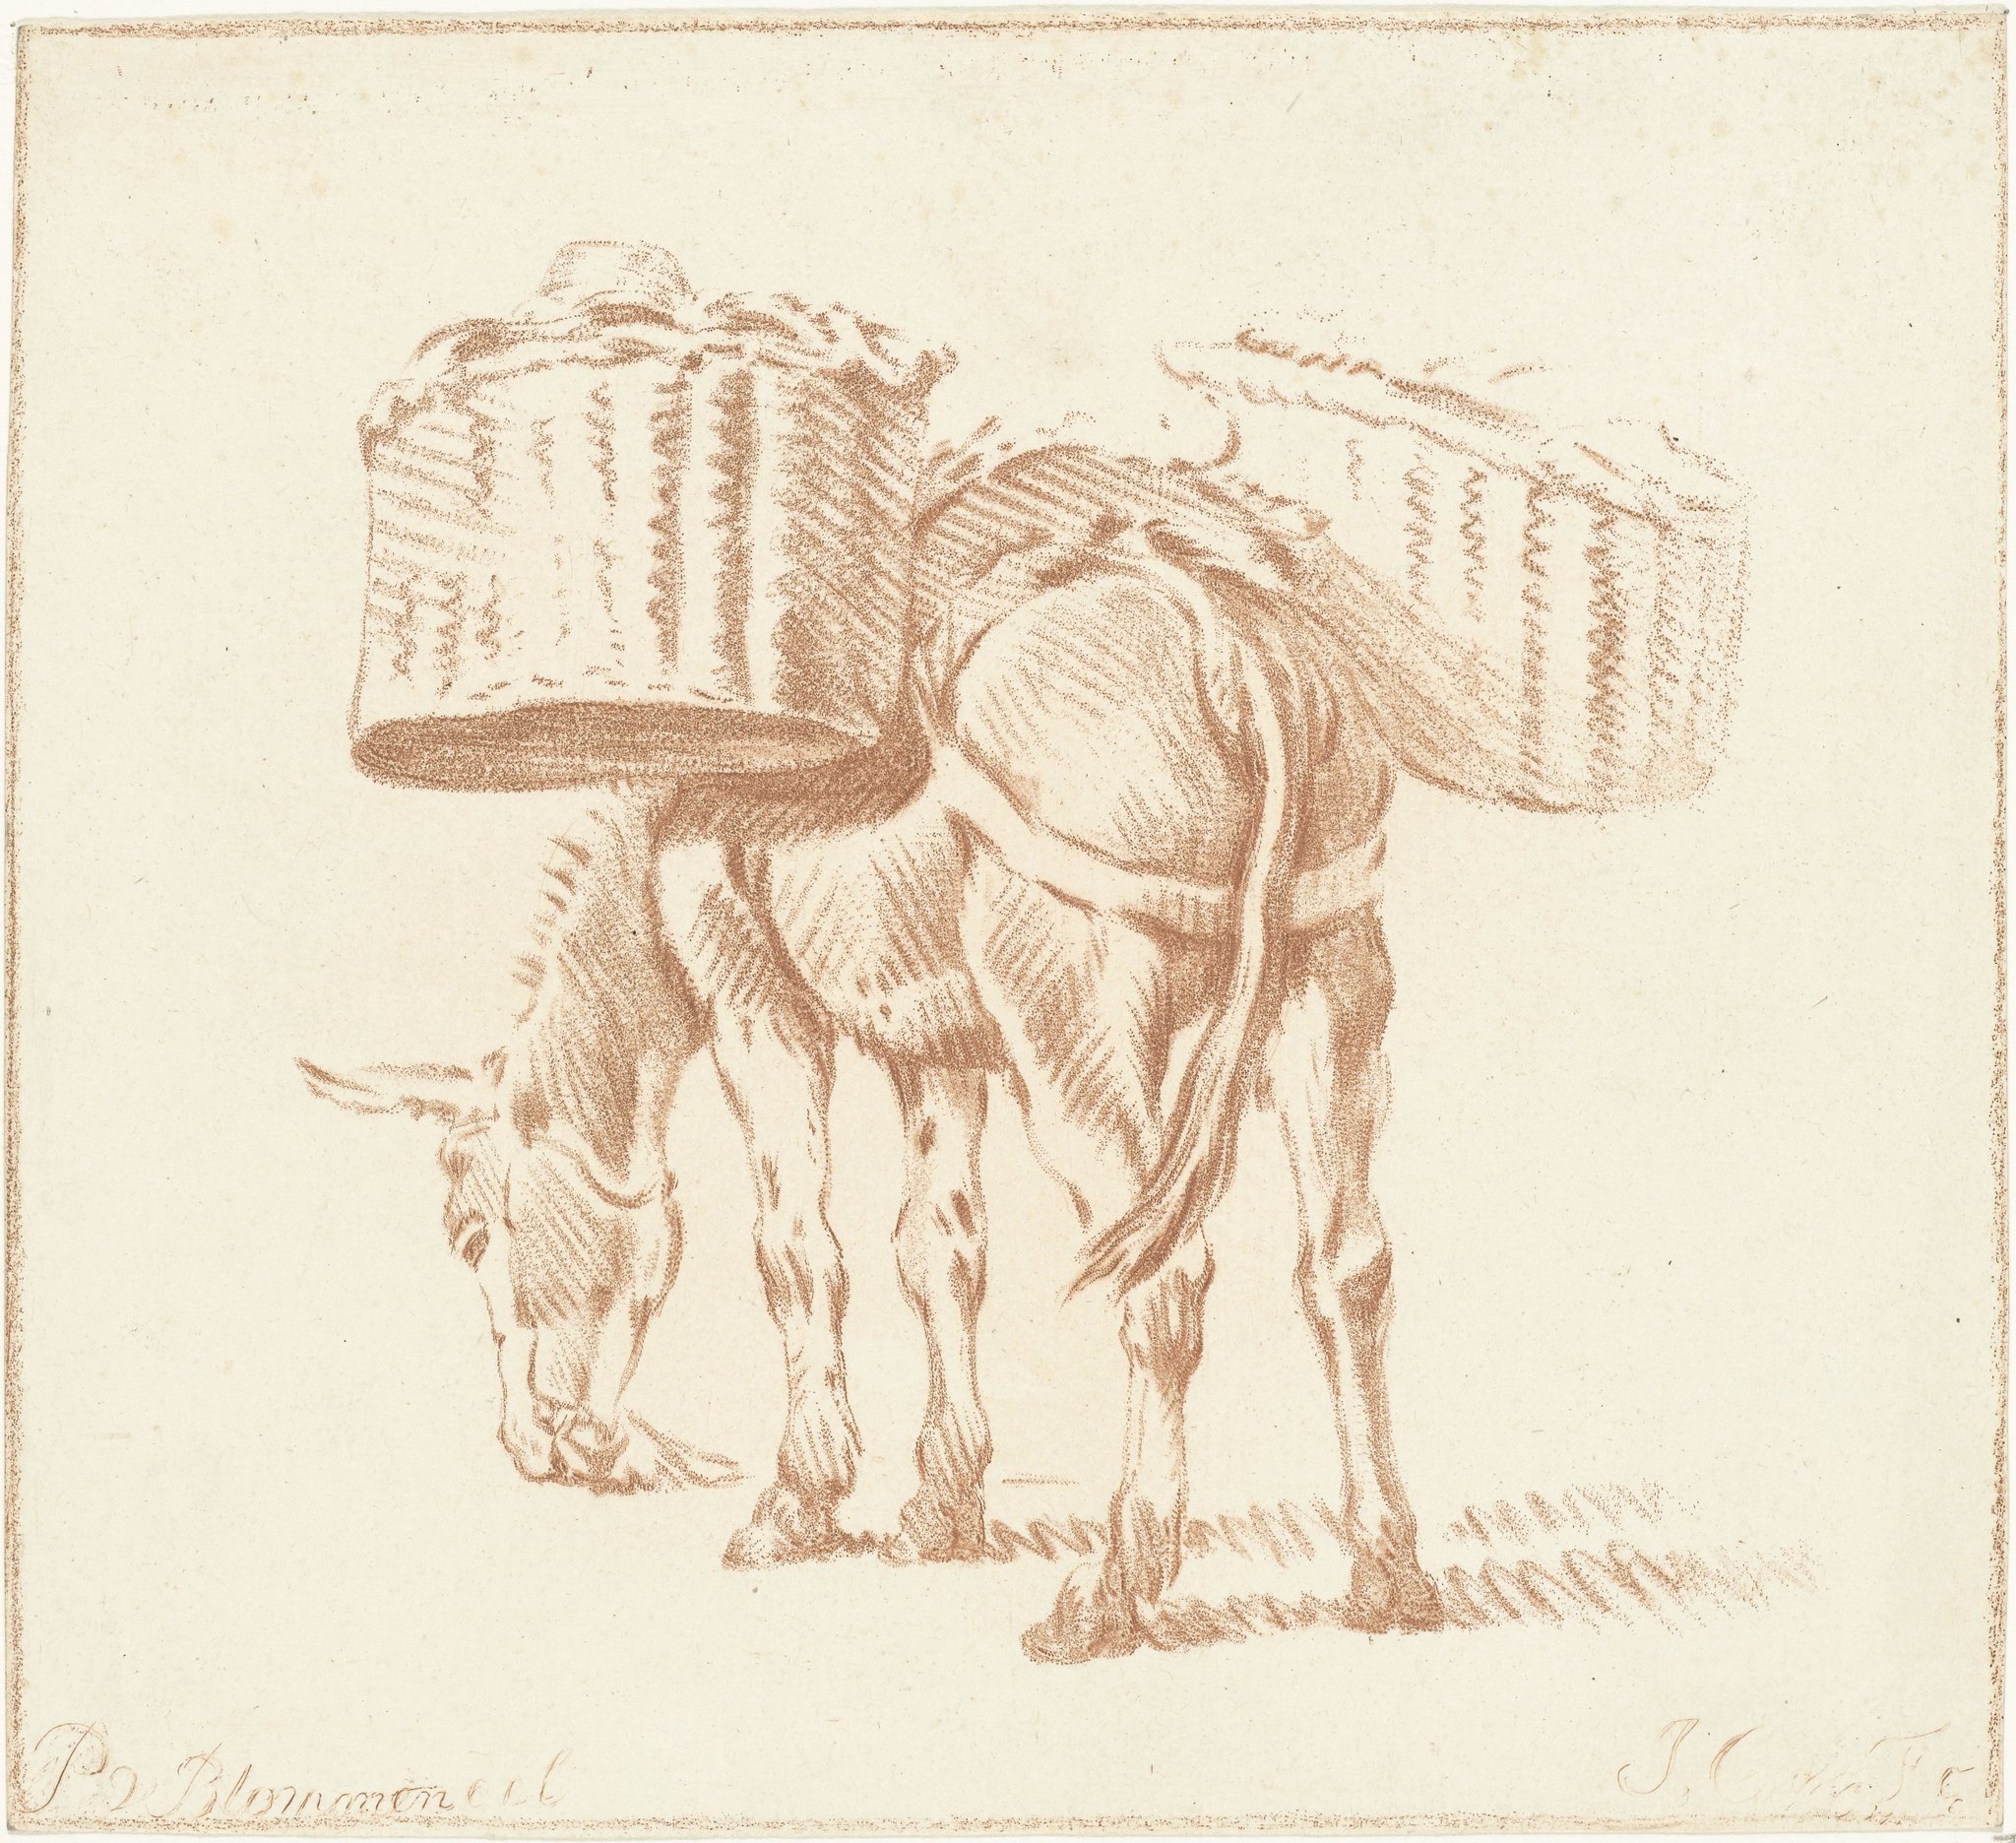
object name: print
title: Beladen ezel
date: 1724-1798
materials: paper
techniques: printmaking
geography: amsterdam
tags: pack-animal, ass, donkey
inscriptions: collector's mark: Lugt 2228